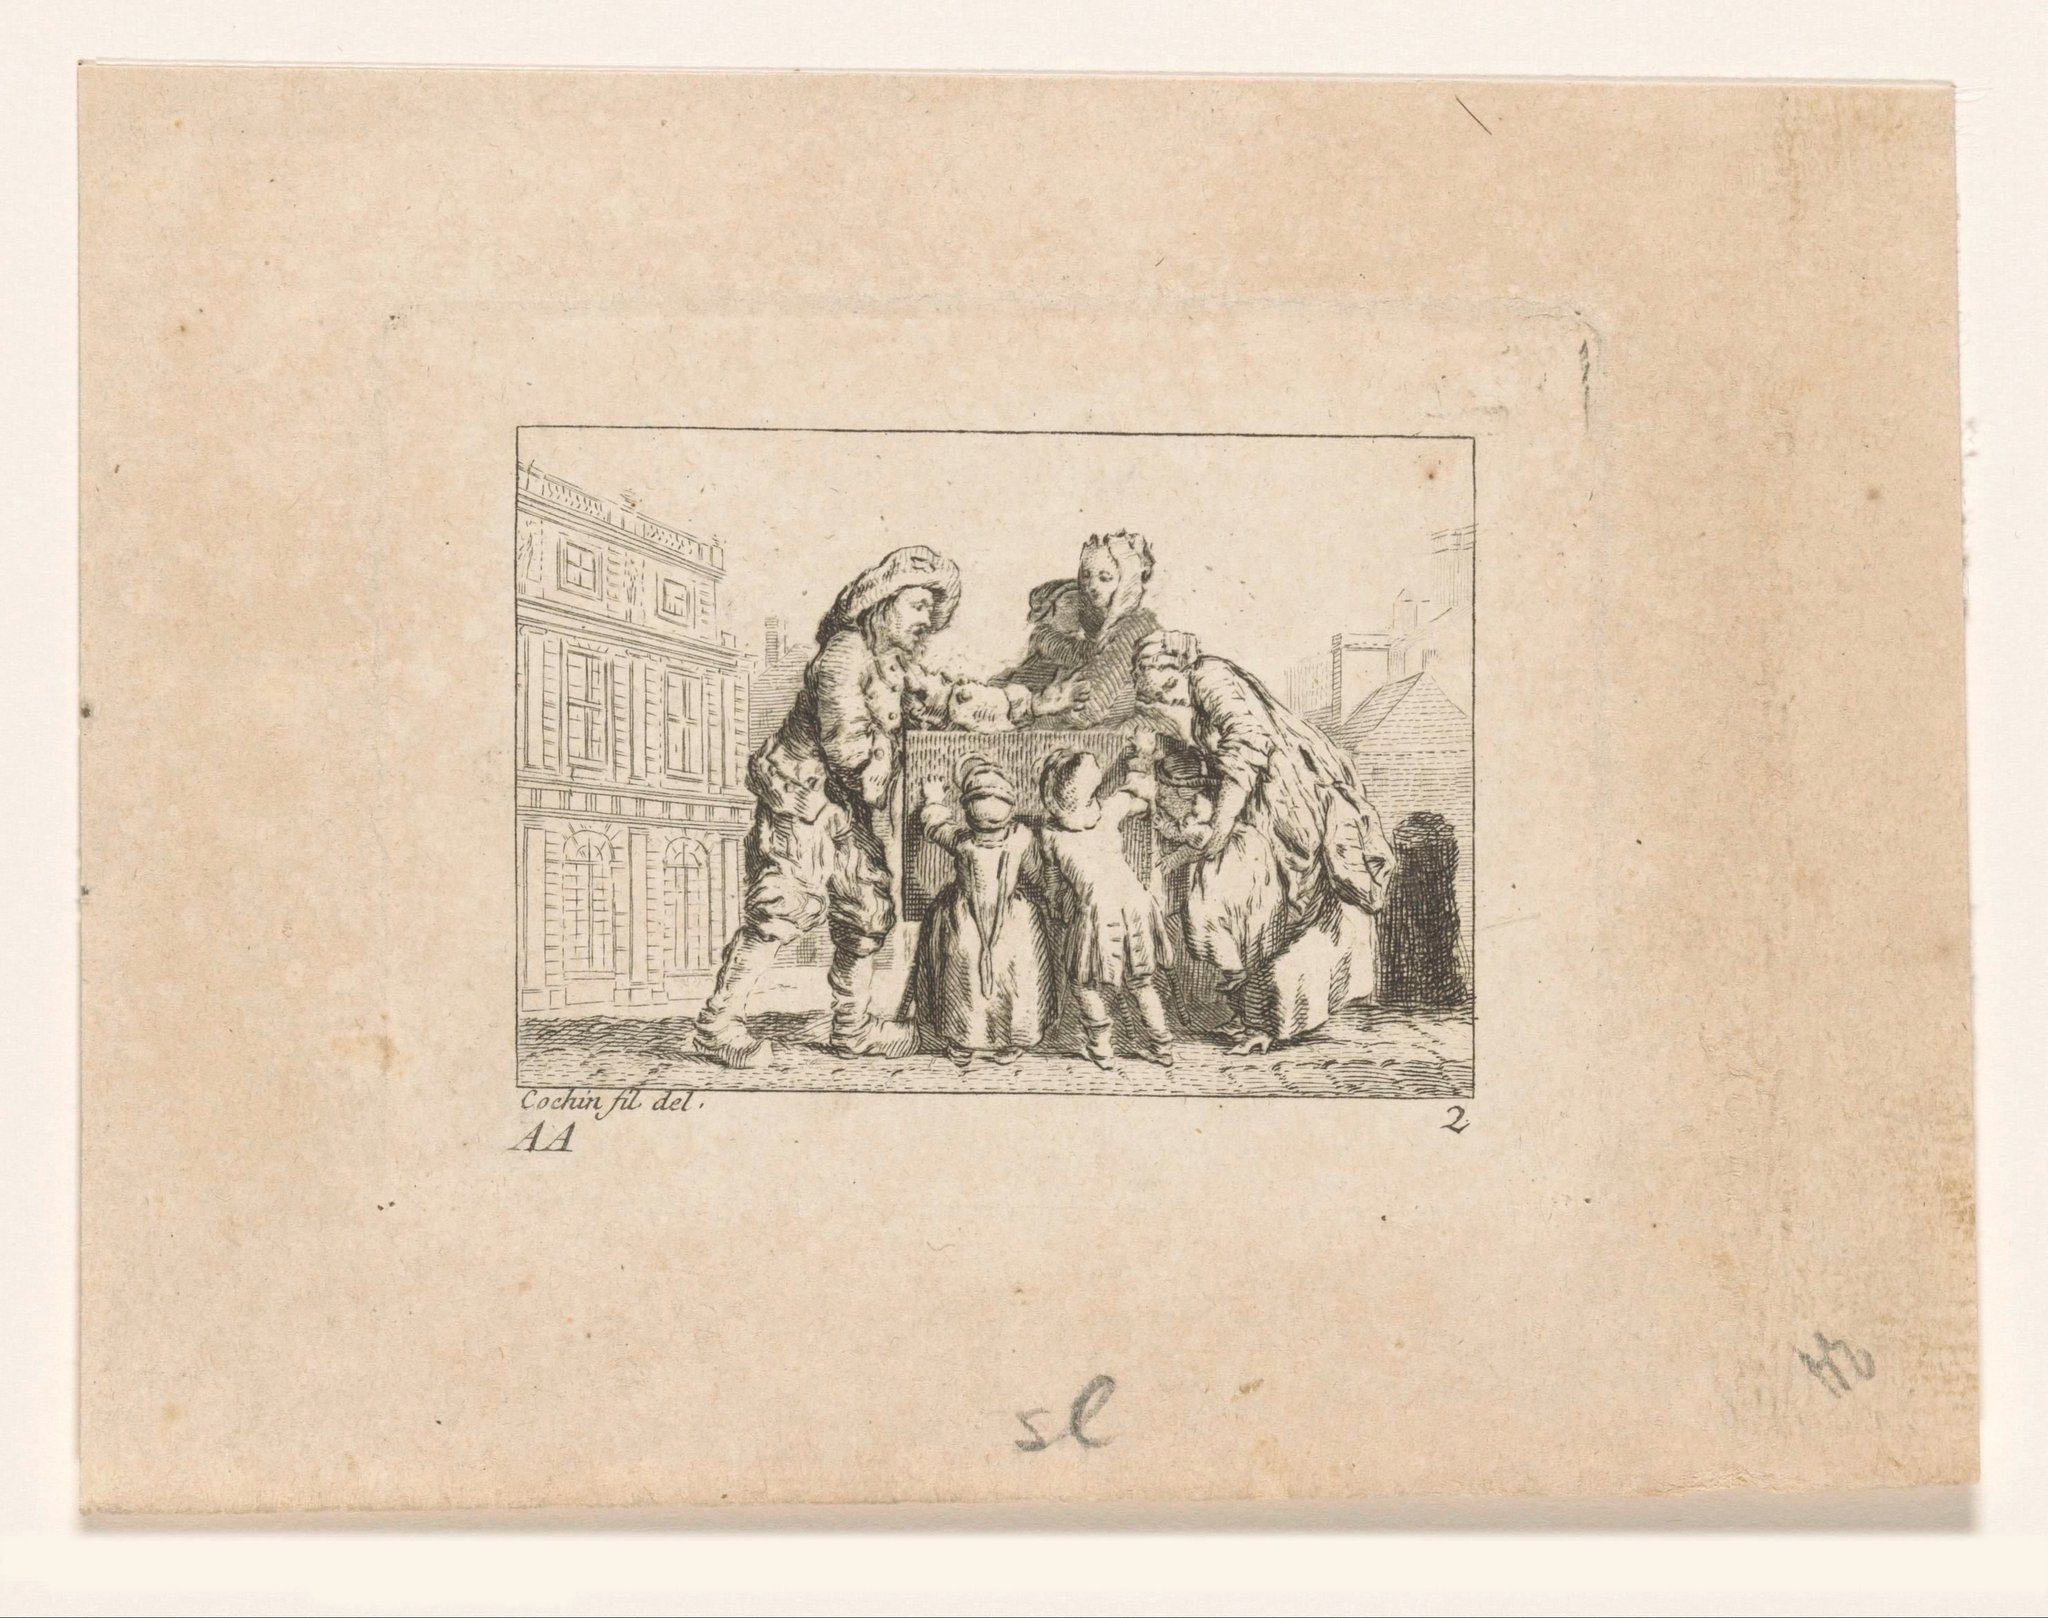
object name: print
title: Kinderen en volwassenen rond een prentkast op een plein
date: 1725-1790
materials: paper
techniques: etching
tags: performance in the open air (pleasure fair), peep-show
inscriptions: collector's mark: Lugt 2228, collector's mark: Lugt 4779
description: Rechtsonder genummerd: 2; linksonder AA.